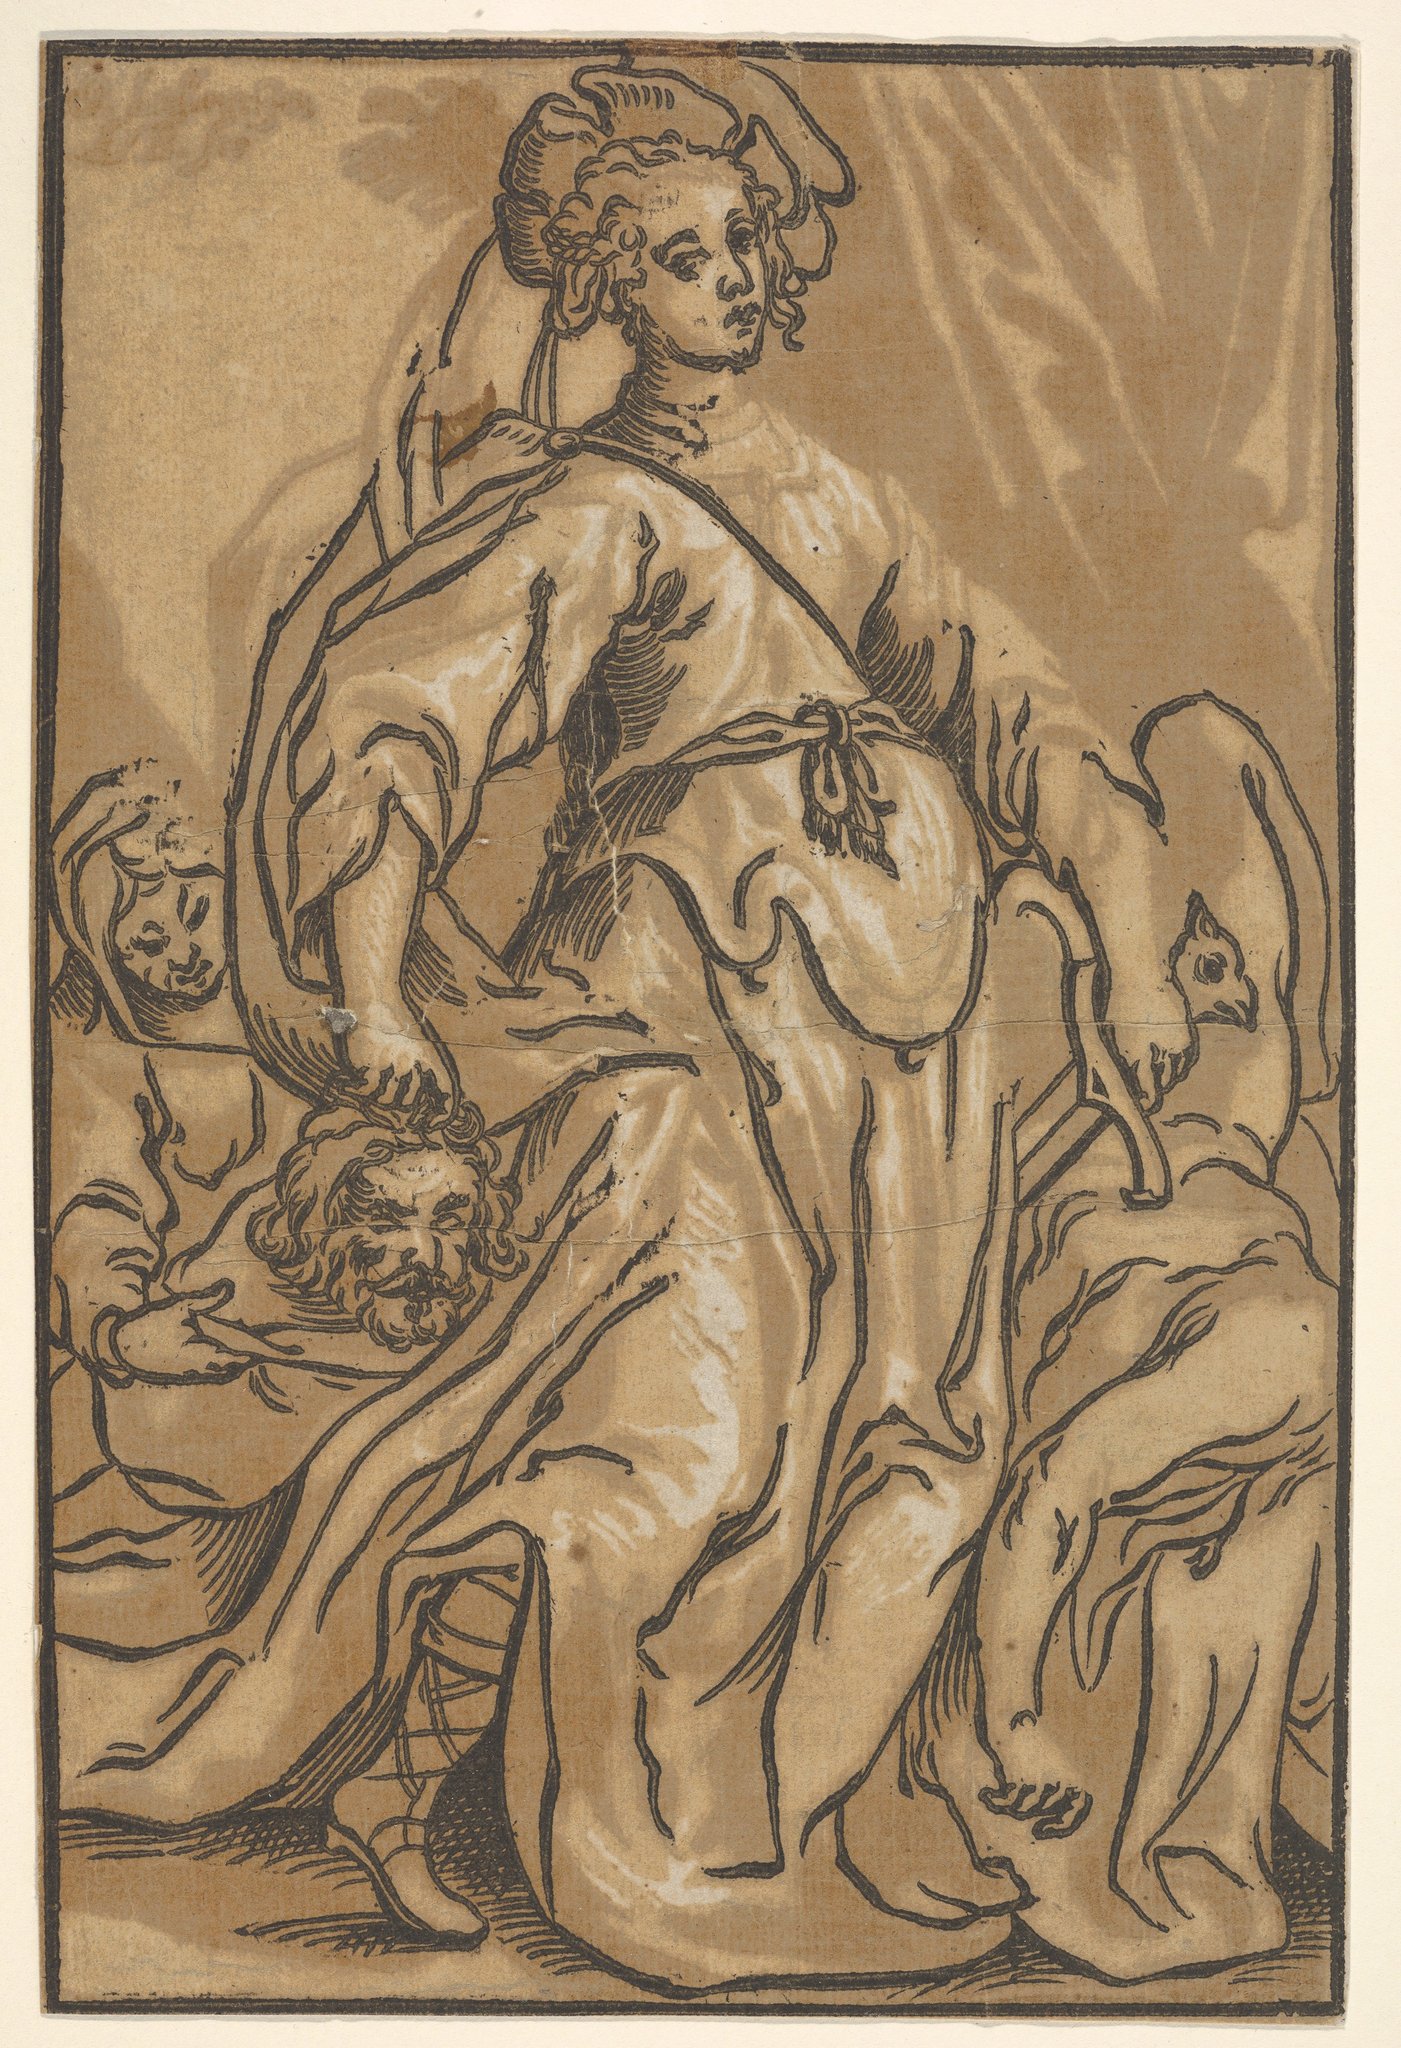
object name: print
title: Judith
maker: ludolf büsinck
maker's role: artist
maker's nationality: german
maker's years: 1599-1669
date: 1610-1669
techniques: woodcut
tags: judith